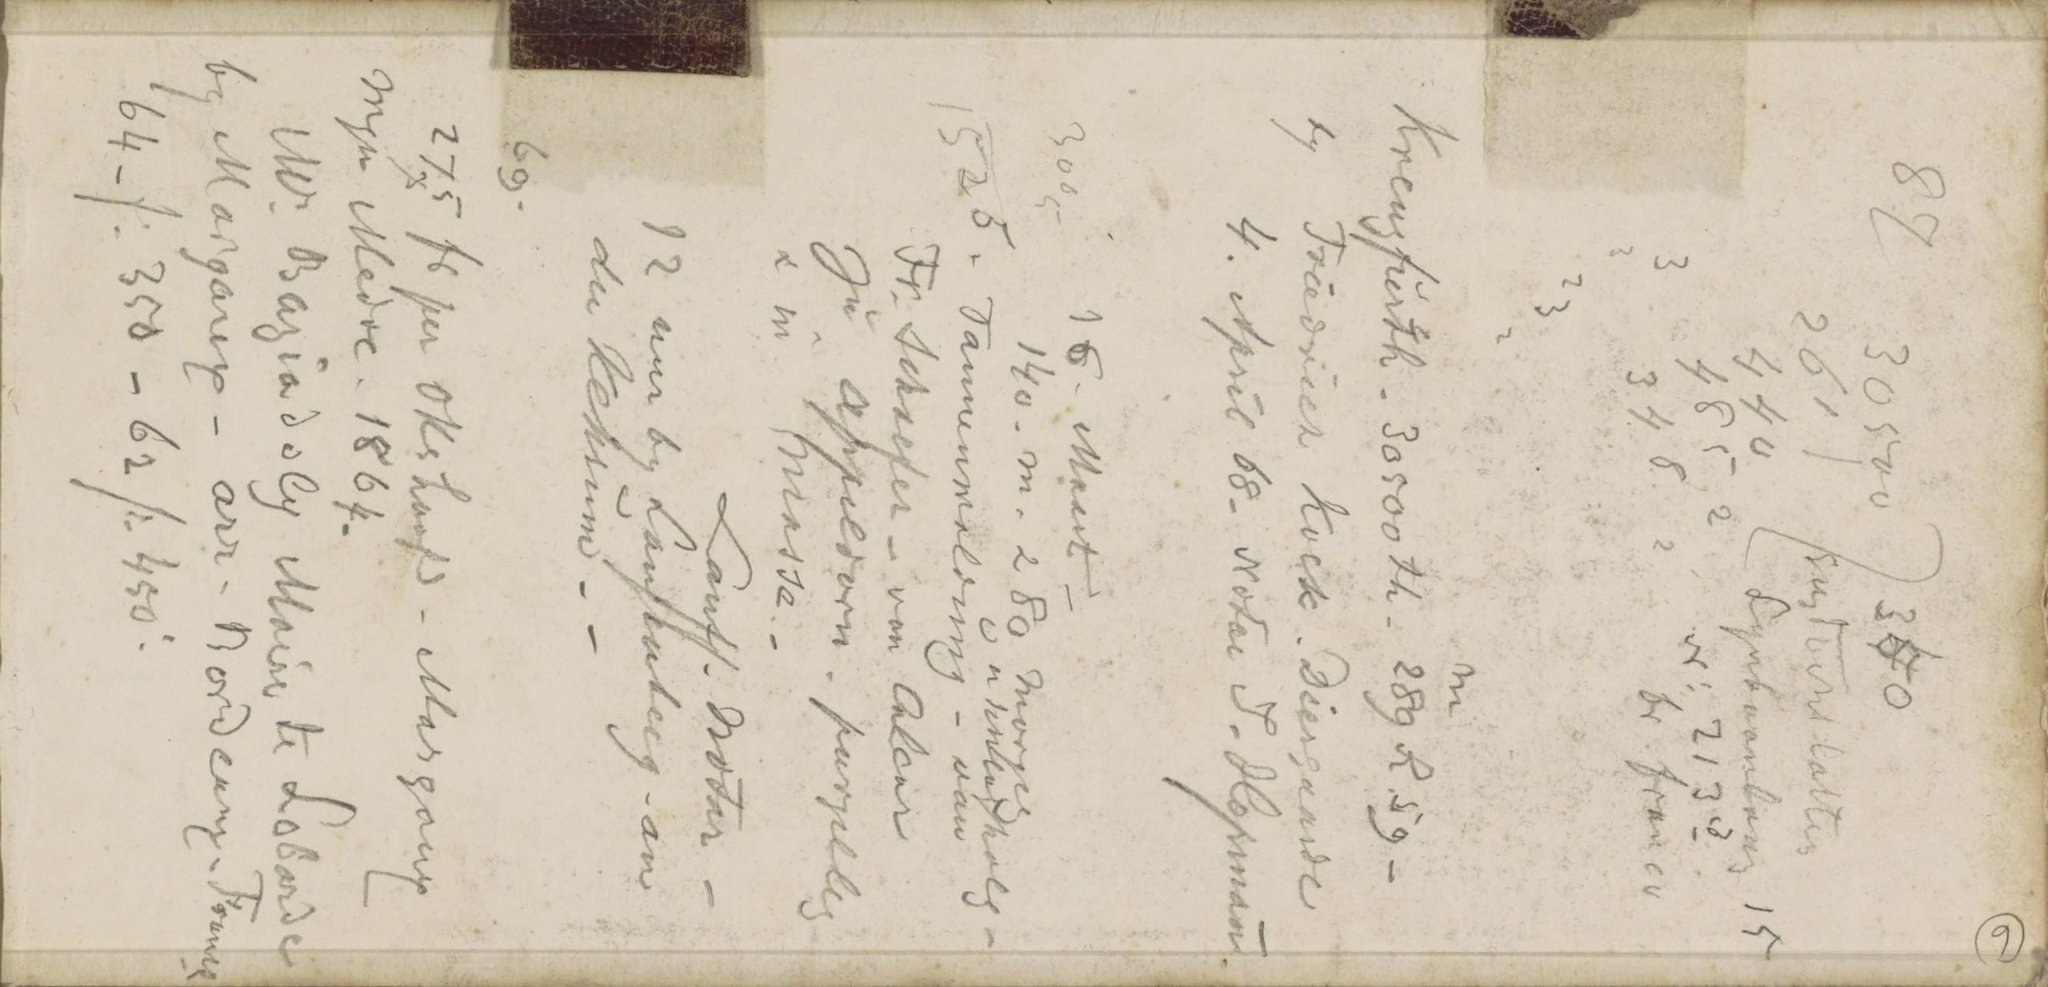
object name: sketchbook leaf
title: Berekeningen en reisschema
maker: johannes tavenraat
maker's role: draughtsman, painter, print maker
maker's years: 1809-1881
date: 1840-1868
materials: paper, pencil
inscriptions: annotation: ‘[...]’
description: Achterste schutblad uit een schetsboek met 63 bladen.